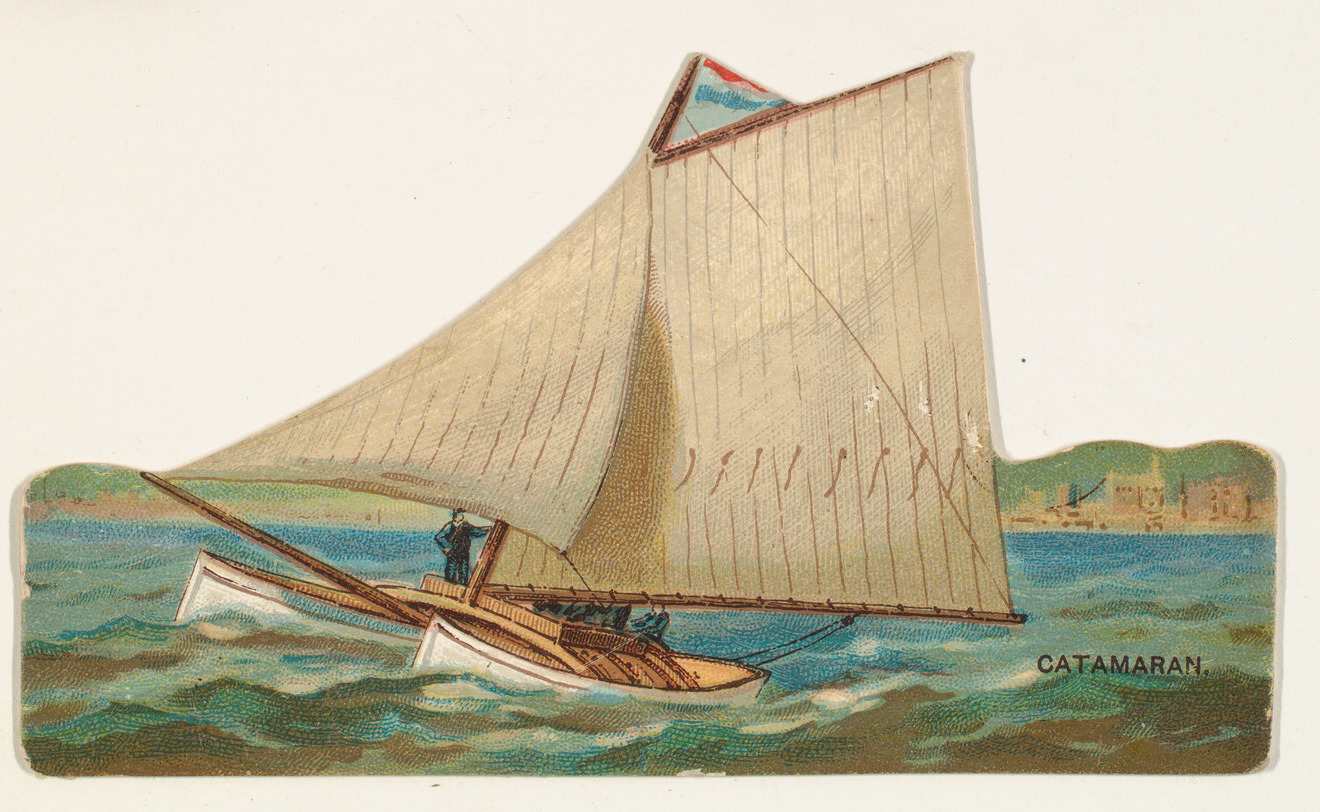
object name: print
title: Catamaran, from the Types of Vessels series (N139) issued by Duke Sons & Co. to promote Honest Long Cut Tobacco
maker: w. duke, sons & co.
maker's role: publisher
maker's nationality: american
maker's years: 1870-1920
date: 1889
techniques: color lithograph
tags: boats